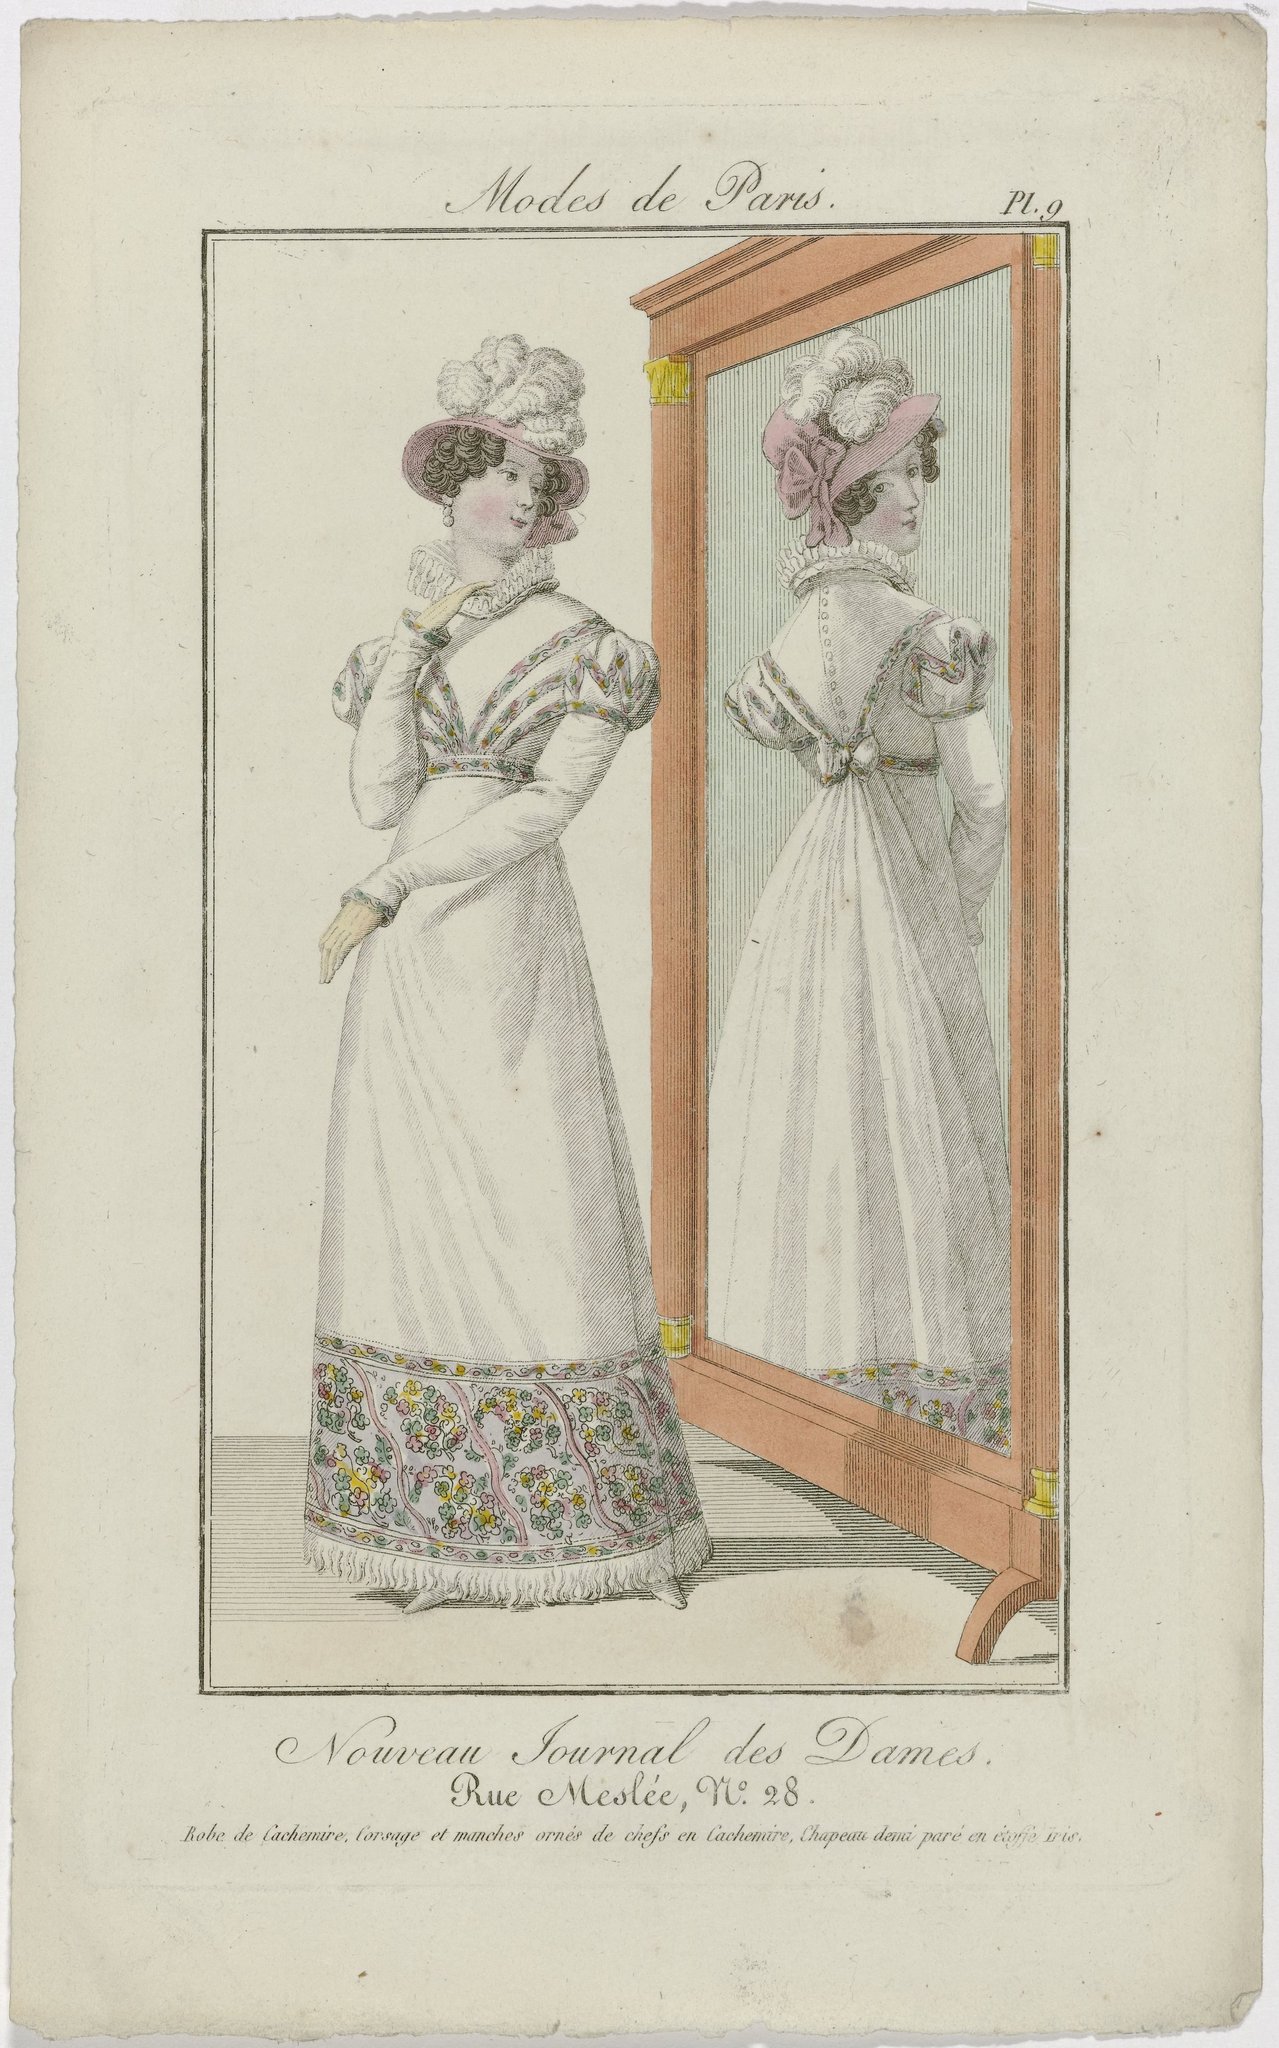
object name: fashion print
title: Nouveau Journal des Dames, 1821, Pl. 9 : Robe de Cachemir (...)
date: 1821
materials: paper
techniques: engraving, hand coloring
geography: paris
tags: looking in the mirror; (possibly: contemplation of own beauty - aa - (for) women), fashion plates, head-gear: hat (+ women's clothes), shoes, sandals (+ women's clothes), gloves, mittens, etc. (+ women's clothes), dress, gown (+ women's clothes), neck-gear ~ clothing (+ women's clothes)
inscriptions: caption: ‘Robe de Cachemire, Corsage et manches ornés de chefs en Cachemire, Chapeau demi paré en étoffe Iris.’, title: ‘Nouveau Journal des Dames.’, title: ‘Modes de Paris.’, address: ‘Rue Meslée, No. 28.’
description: Staande vrouw, met de rug naar een passpiegel, gekleed in een japon van kasjmier. Lijfje en mouwen versierd met 'chefs' (biezen?) van kasjmier. 'Chapeau demi paré en étoffe Iris.' Verdere accessoires: oorbel in het rechteroor, handschoenen. Prent uit het modetijdschrift Nouveau Journal des Dames, Parijs, van 5 juli 1821 tot eind december 1821. Van januari 1822 tot 1868 was het modetijdschrift getiteld: Petit Courrier des Dames.